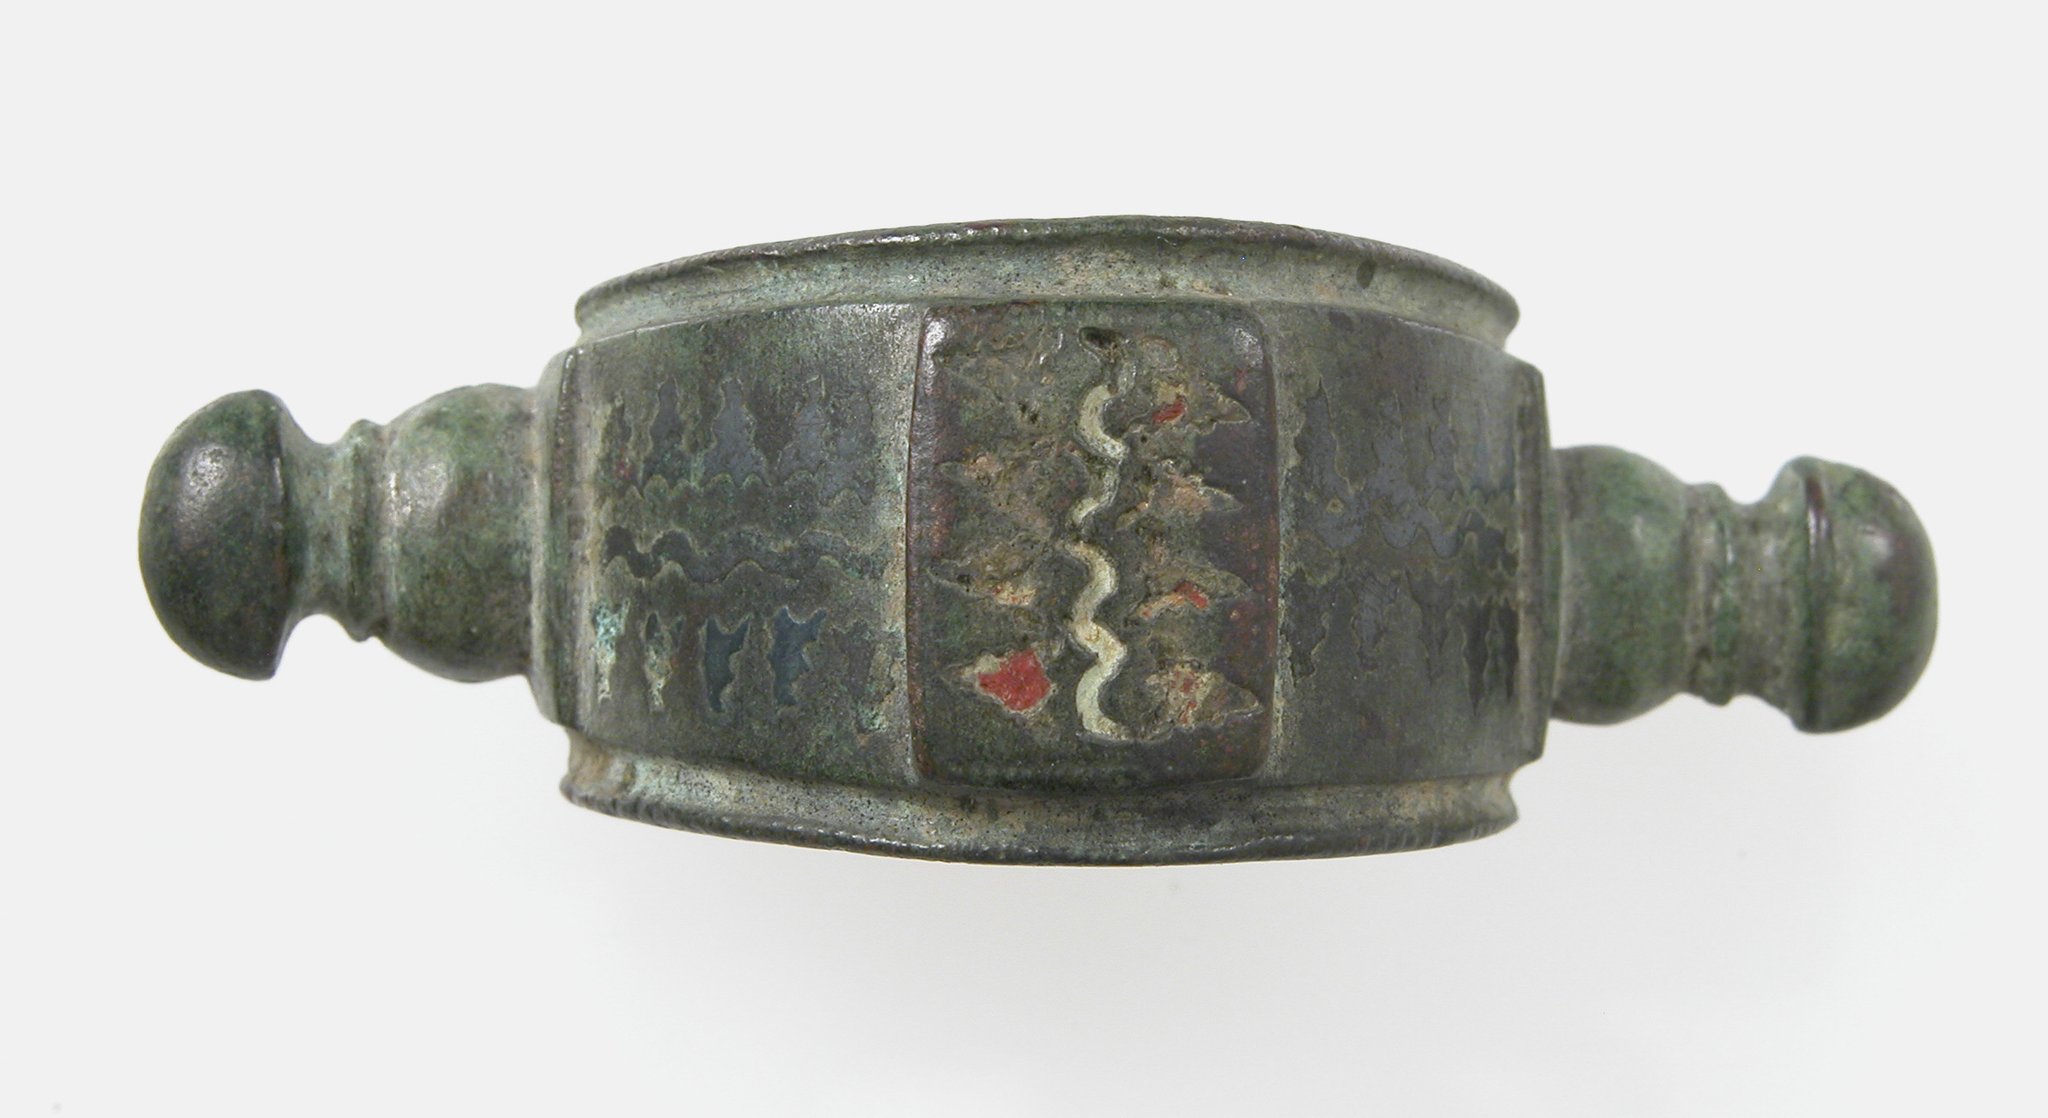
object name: brooch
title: Bow Brooch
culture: roman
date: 101-300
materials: bronze, enamel, silver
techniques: enamel